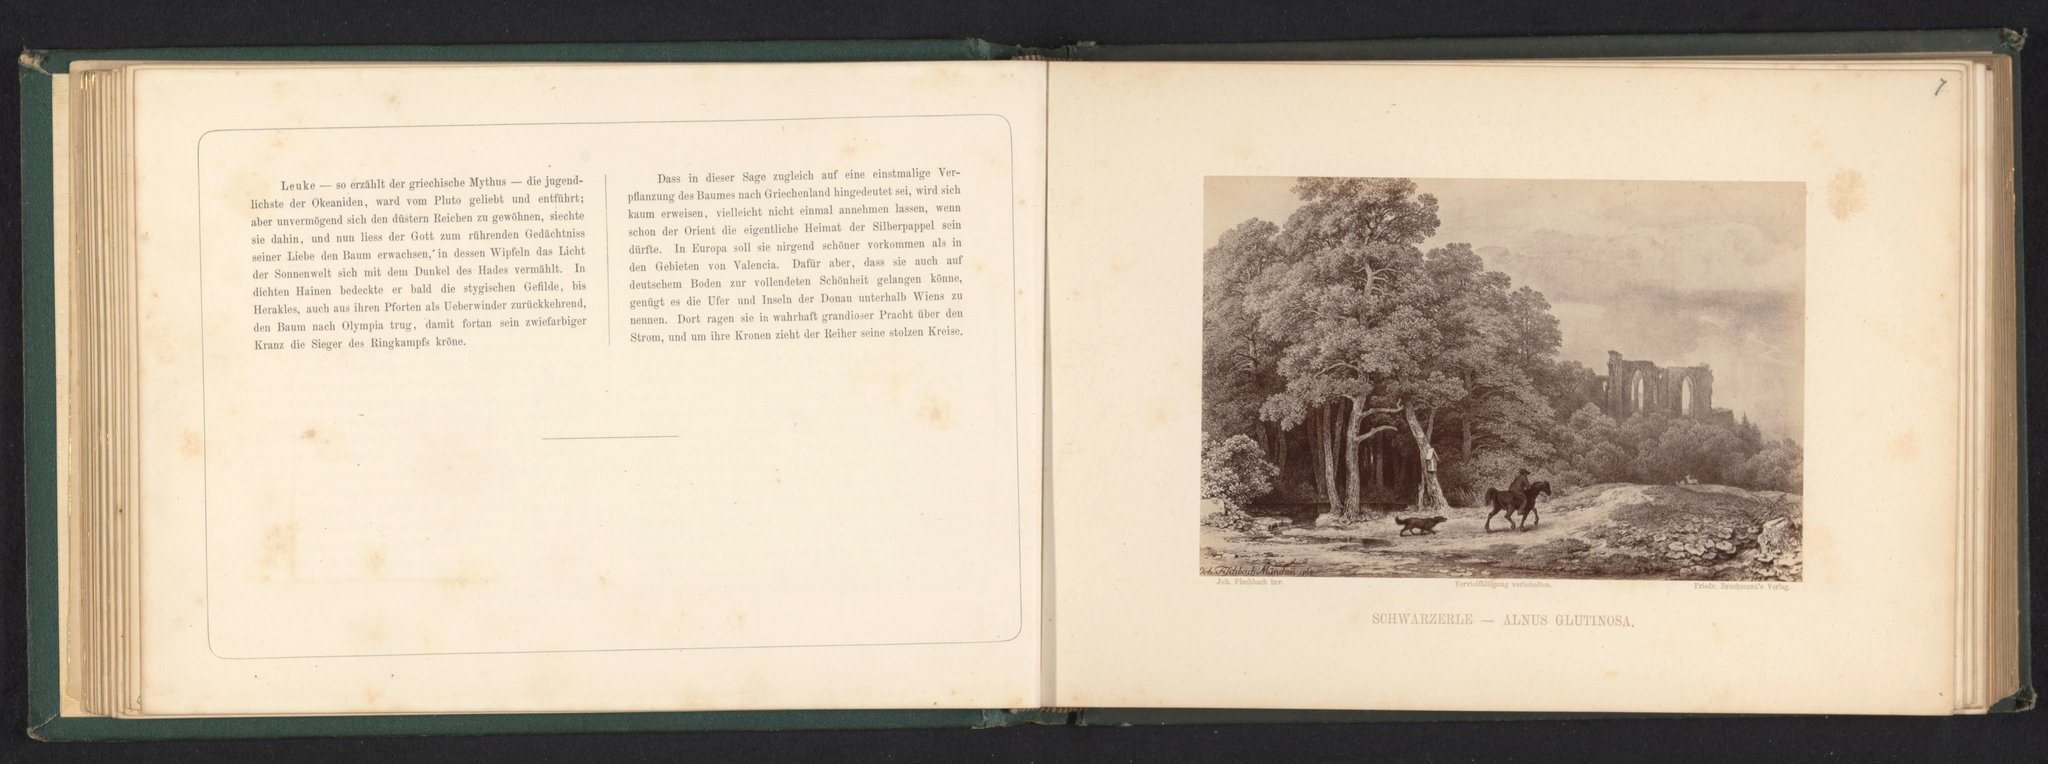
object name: photograph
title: Fotoreproductie van een tekening van een landschap met zwarte elzen, een ruïne en een ruiter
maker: johann fischbach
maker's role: painter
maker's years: 1797-1871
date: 1868-1879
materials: photographic support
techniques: albumen print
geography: munich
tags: trees: alder